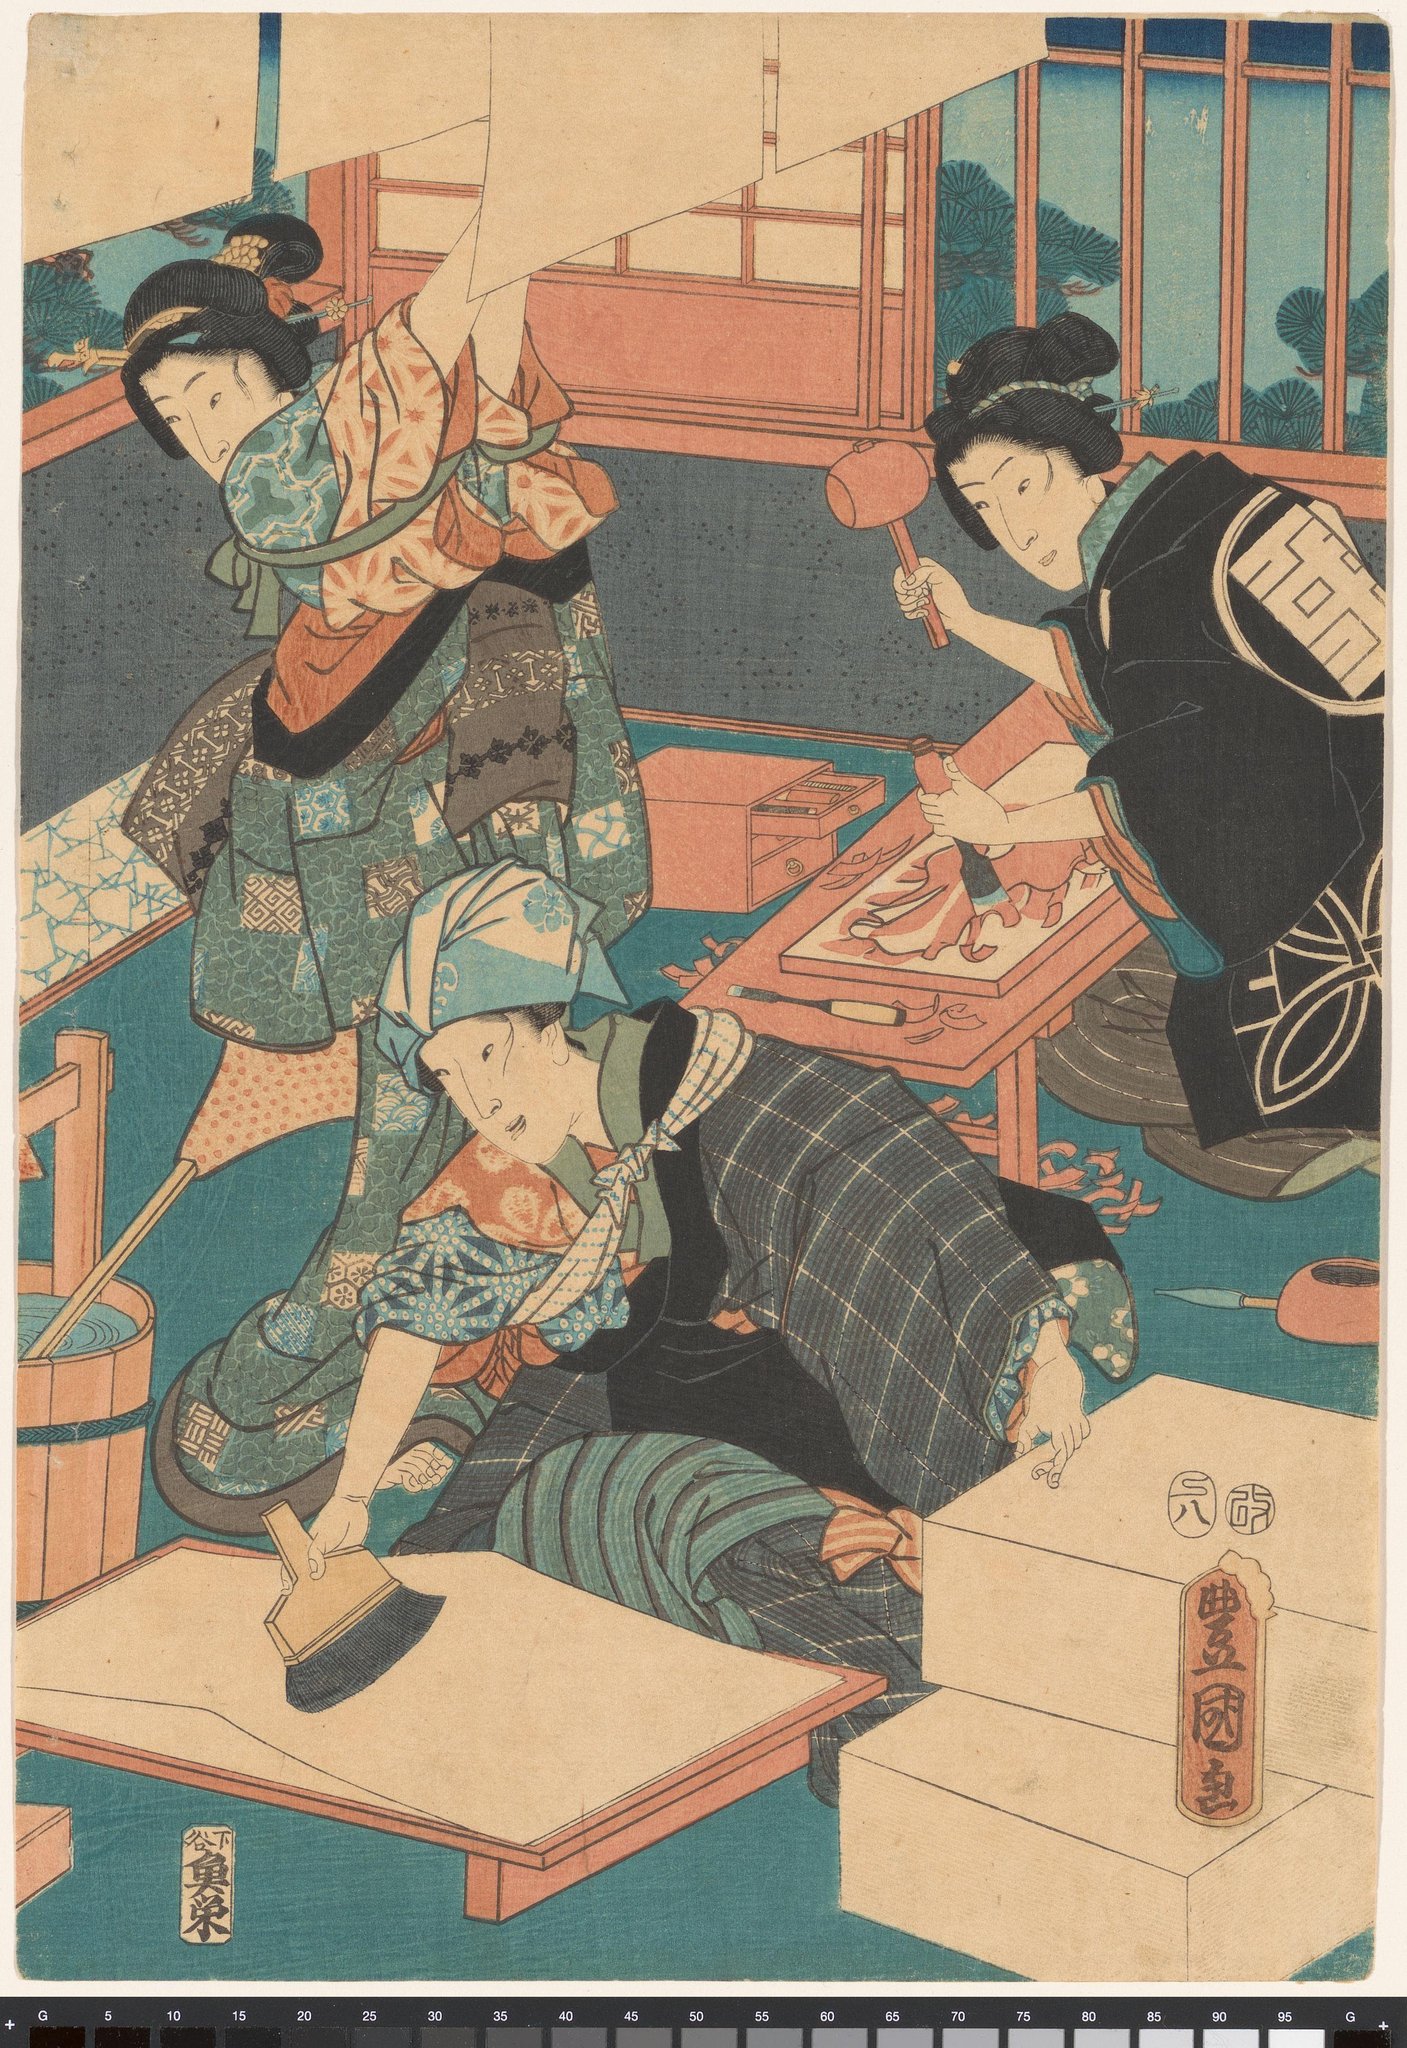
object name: print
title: Vrouwen maken prenten (middendeel)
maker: utagawa kunisada (i)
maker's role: print maker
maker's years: 1786-1865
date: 1796-1865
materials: paper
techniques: blind stamped, woodcut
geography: japan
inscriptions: collector's mark: Lugt 2228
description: Middendeel van een drieluik met vrouwen die prenten maken.